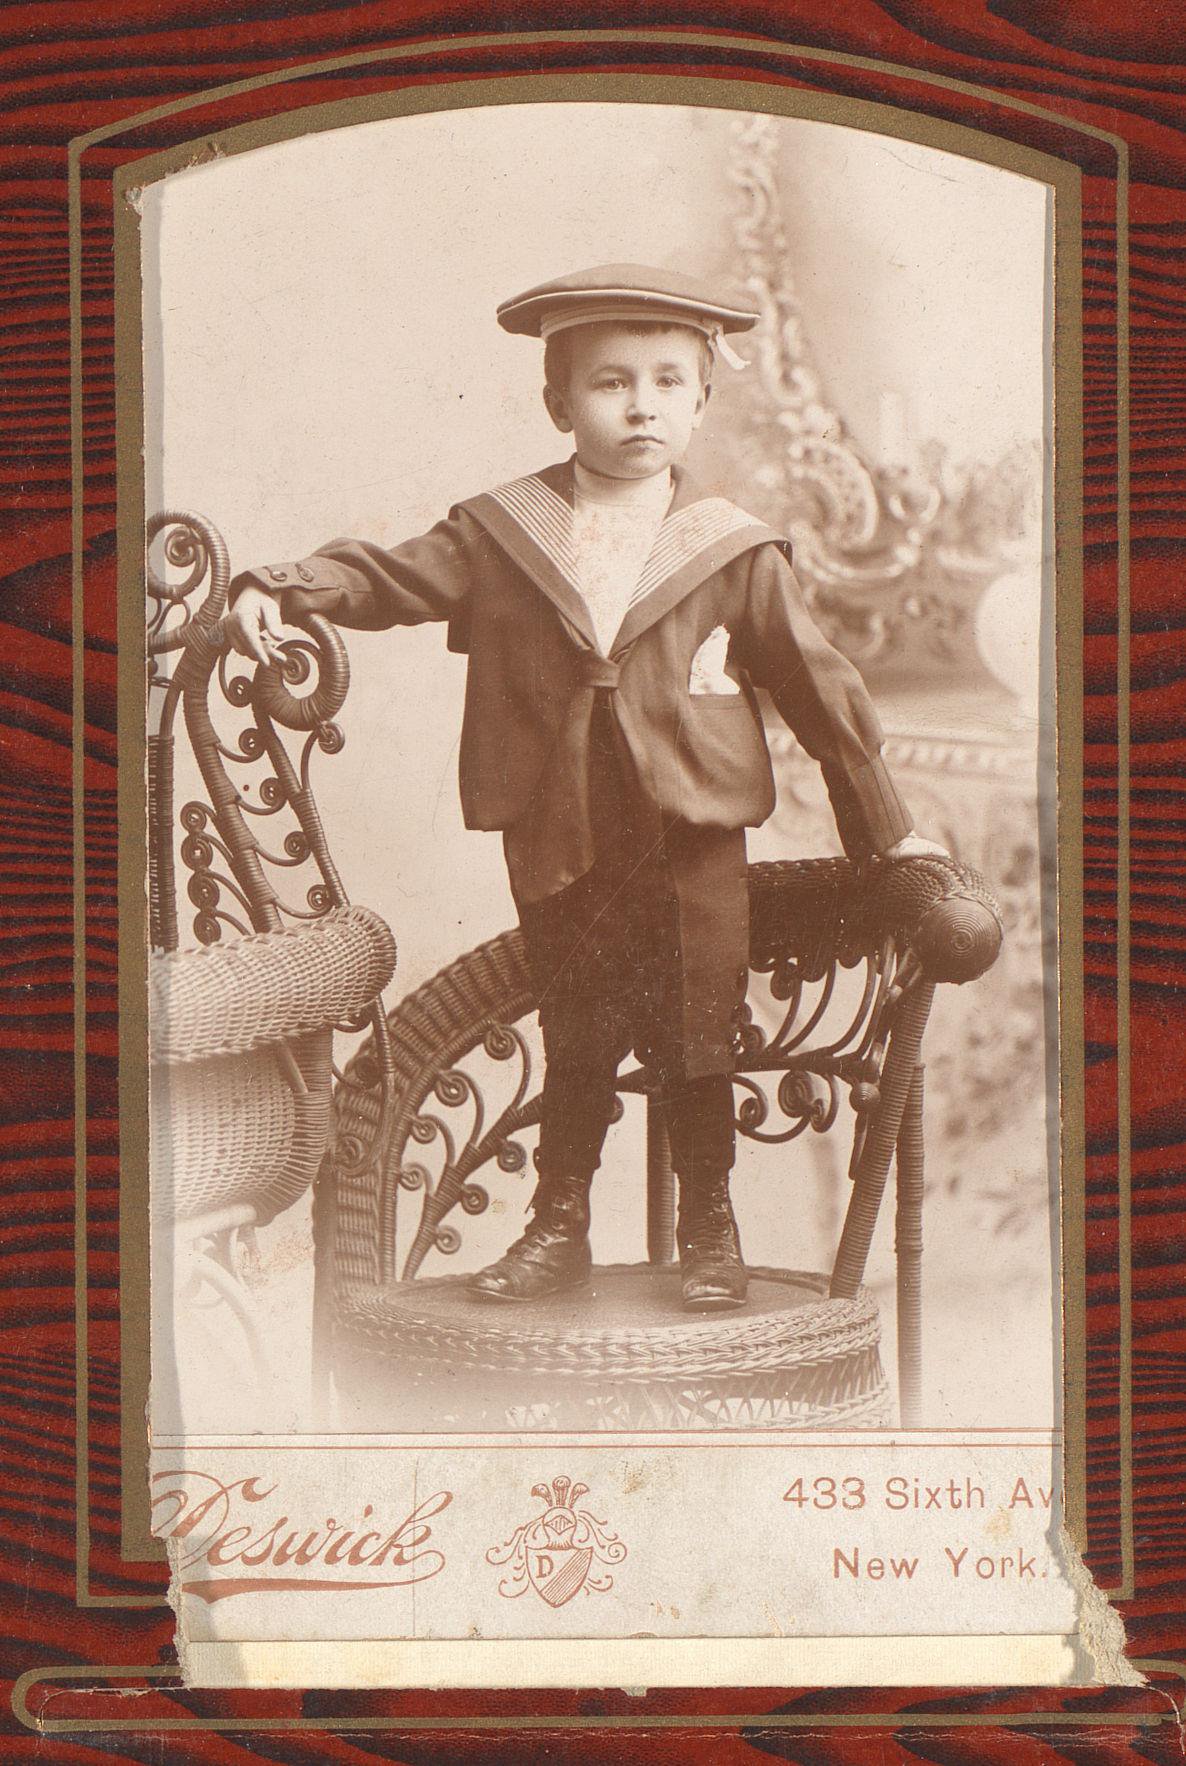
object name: cabinet photograph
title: Portret van een jongen in een matrozenpak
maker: w. jerome deswick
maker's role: fotograaf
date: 1860-1920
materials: cardboard, photographic support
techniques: collodion silver print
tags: boy (child between toddler and youth), historical persons